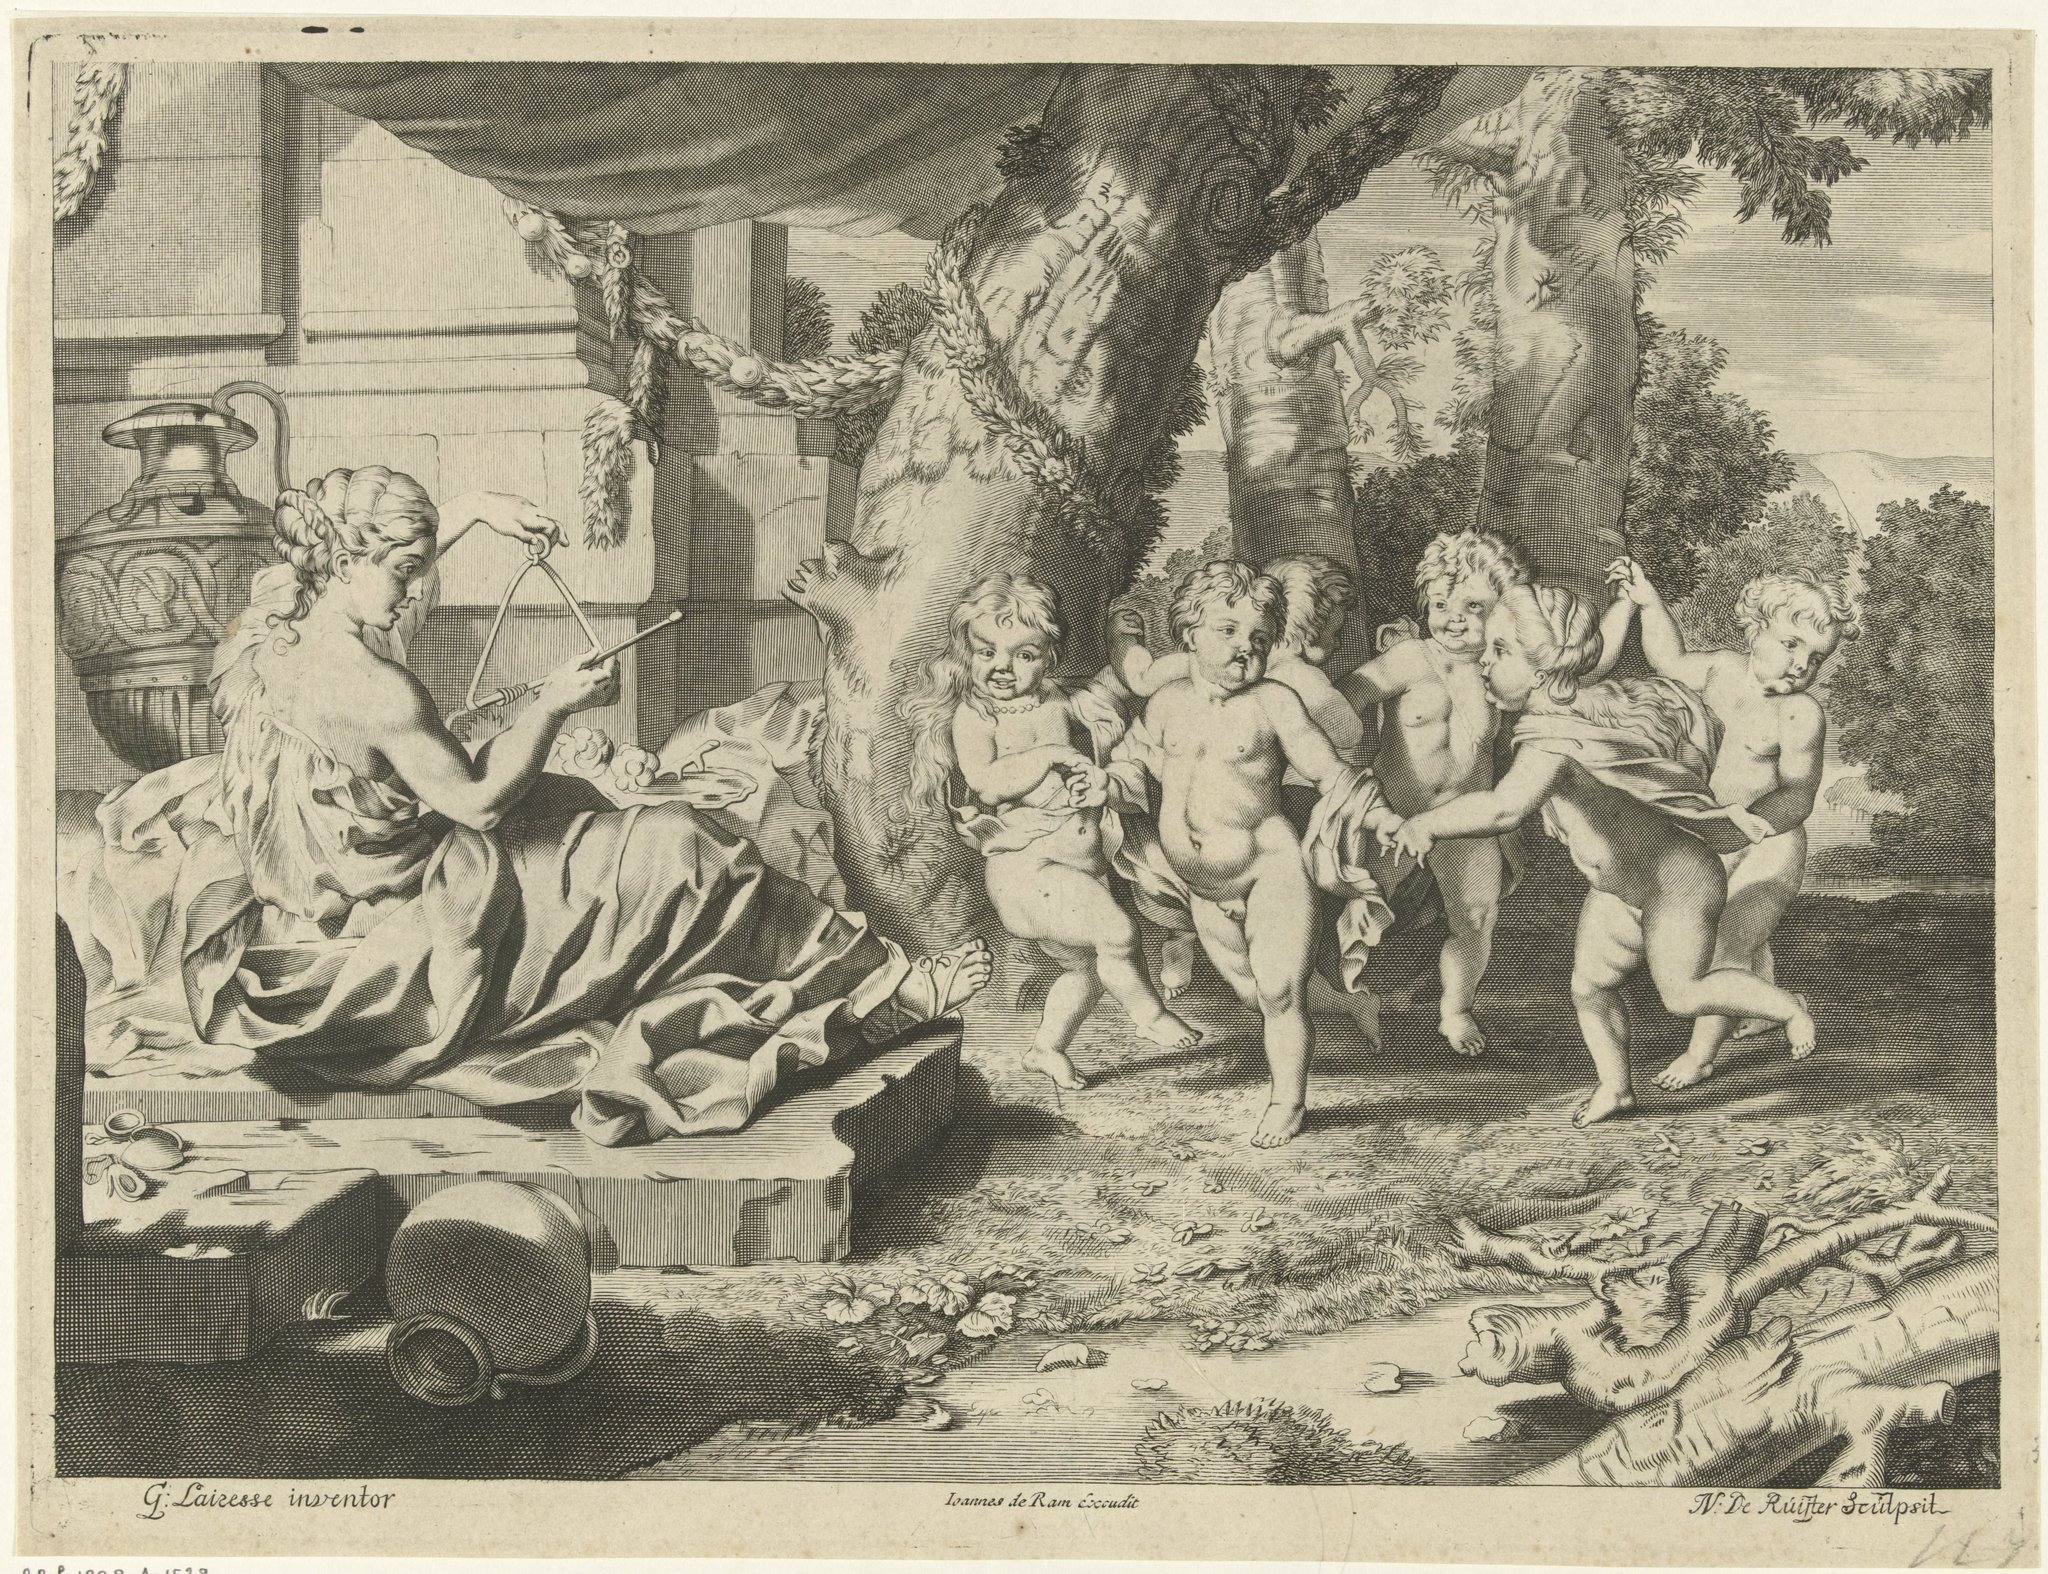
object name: print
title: Allegorie op de muziek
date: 1658-1693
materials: paper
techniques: engraving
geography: amsterdam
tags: other percussion instruments (with name), dancing games (children's games)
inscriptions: collector's mark: Lugt 2228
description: Zes kinderen voeren een rondedans uit op de muziek van een vrouw die triangel speelt.